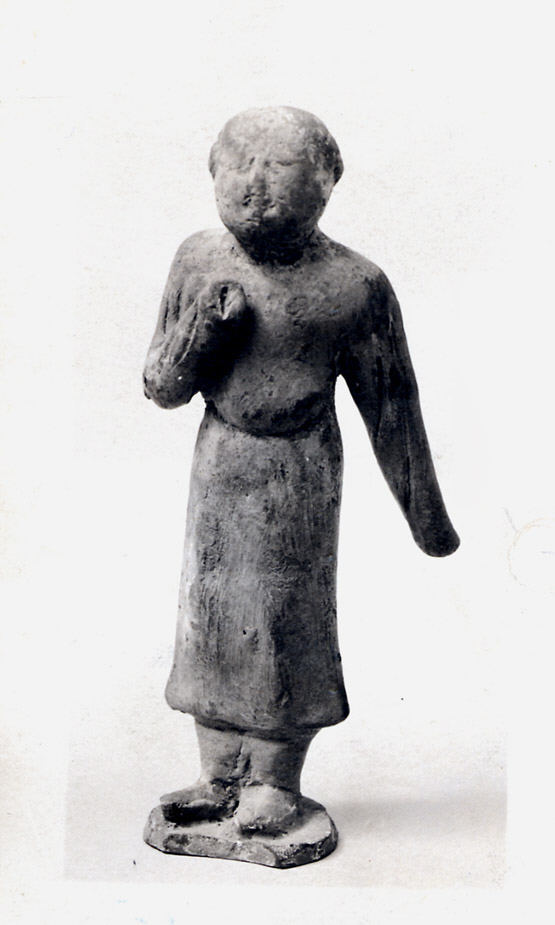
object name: figure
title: Foreigner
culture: chinese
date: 601-800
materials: earthenware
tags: servants